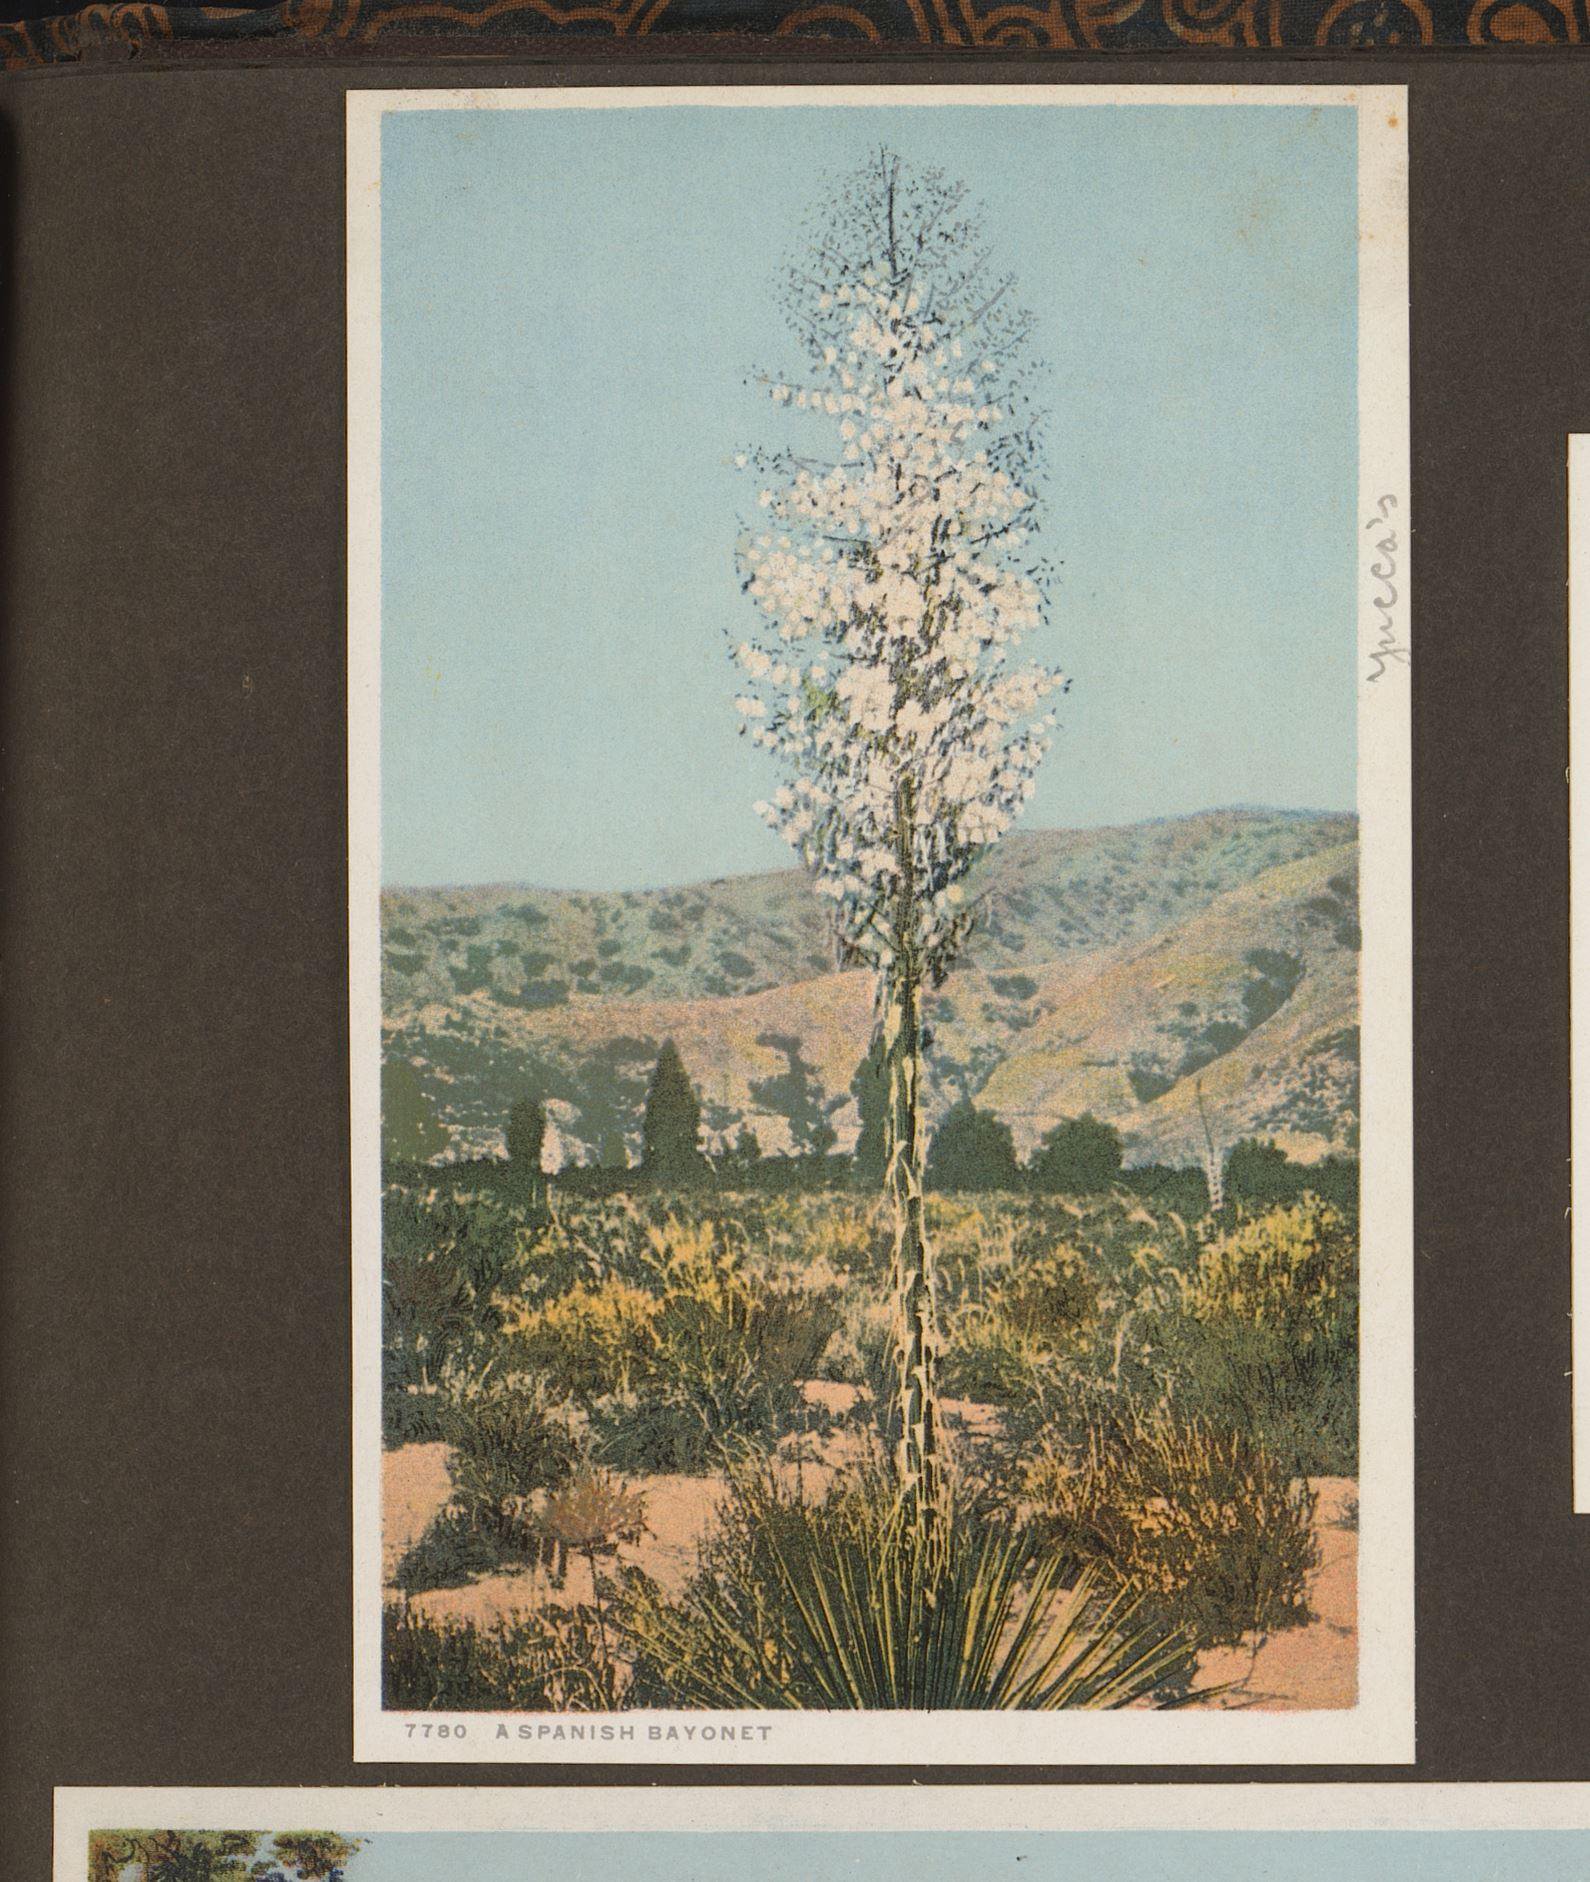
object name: album leaf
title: A Spanish Bayonet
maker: Anonymous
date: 1928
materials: paper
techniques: lithograph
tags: plants (in general), landscapes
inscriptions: number: ‘7780’